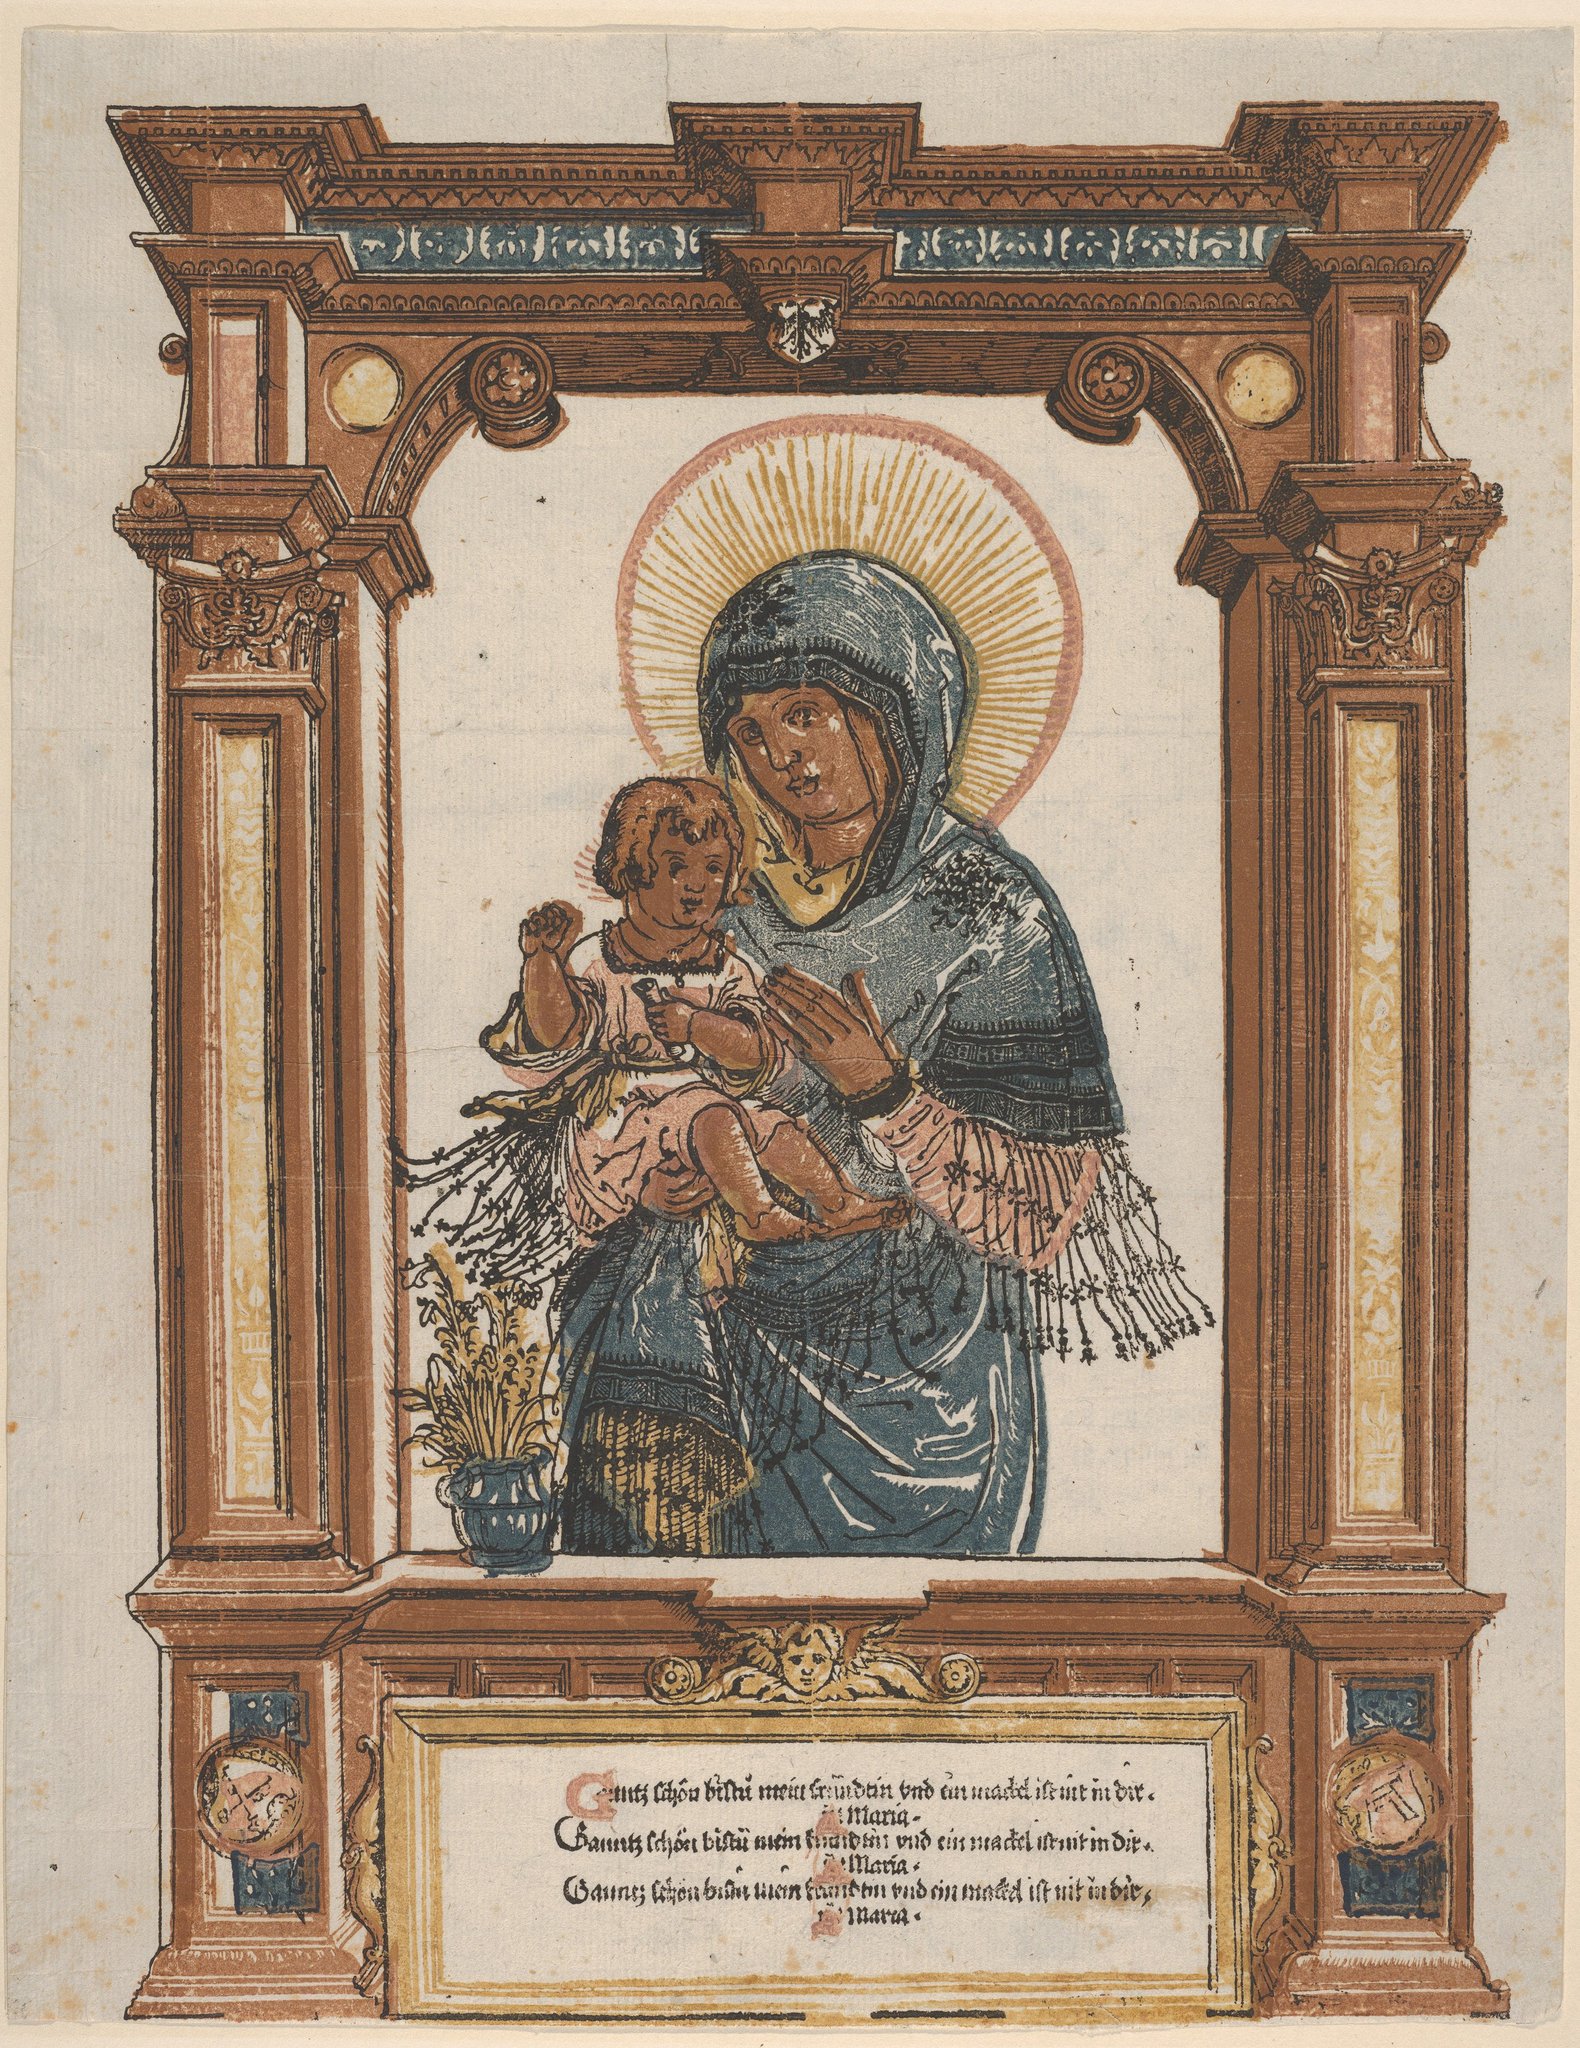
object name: print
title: The Beautiful Virgin of Regensburg in an Architectural Frame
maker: albrecht altdorfer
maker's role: artist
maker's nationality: german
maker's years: 1480-1538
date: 1500-1538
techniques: woodcut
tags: madonna and child